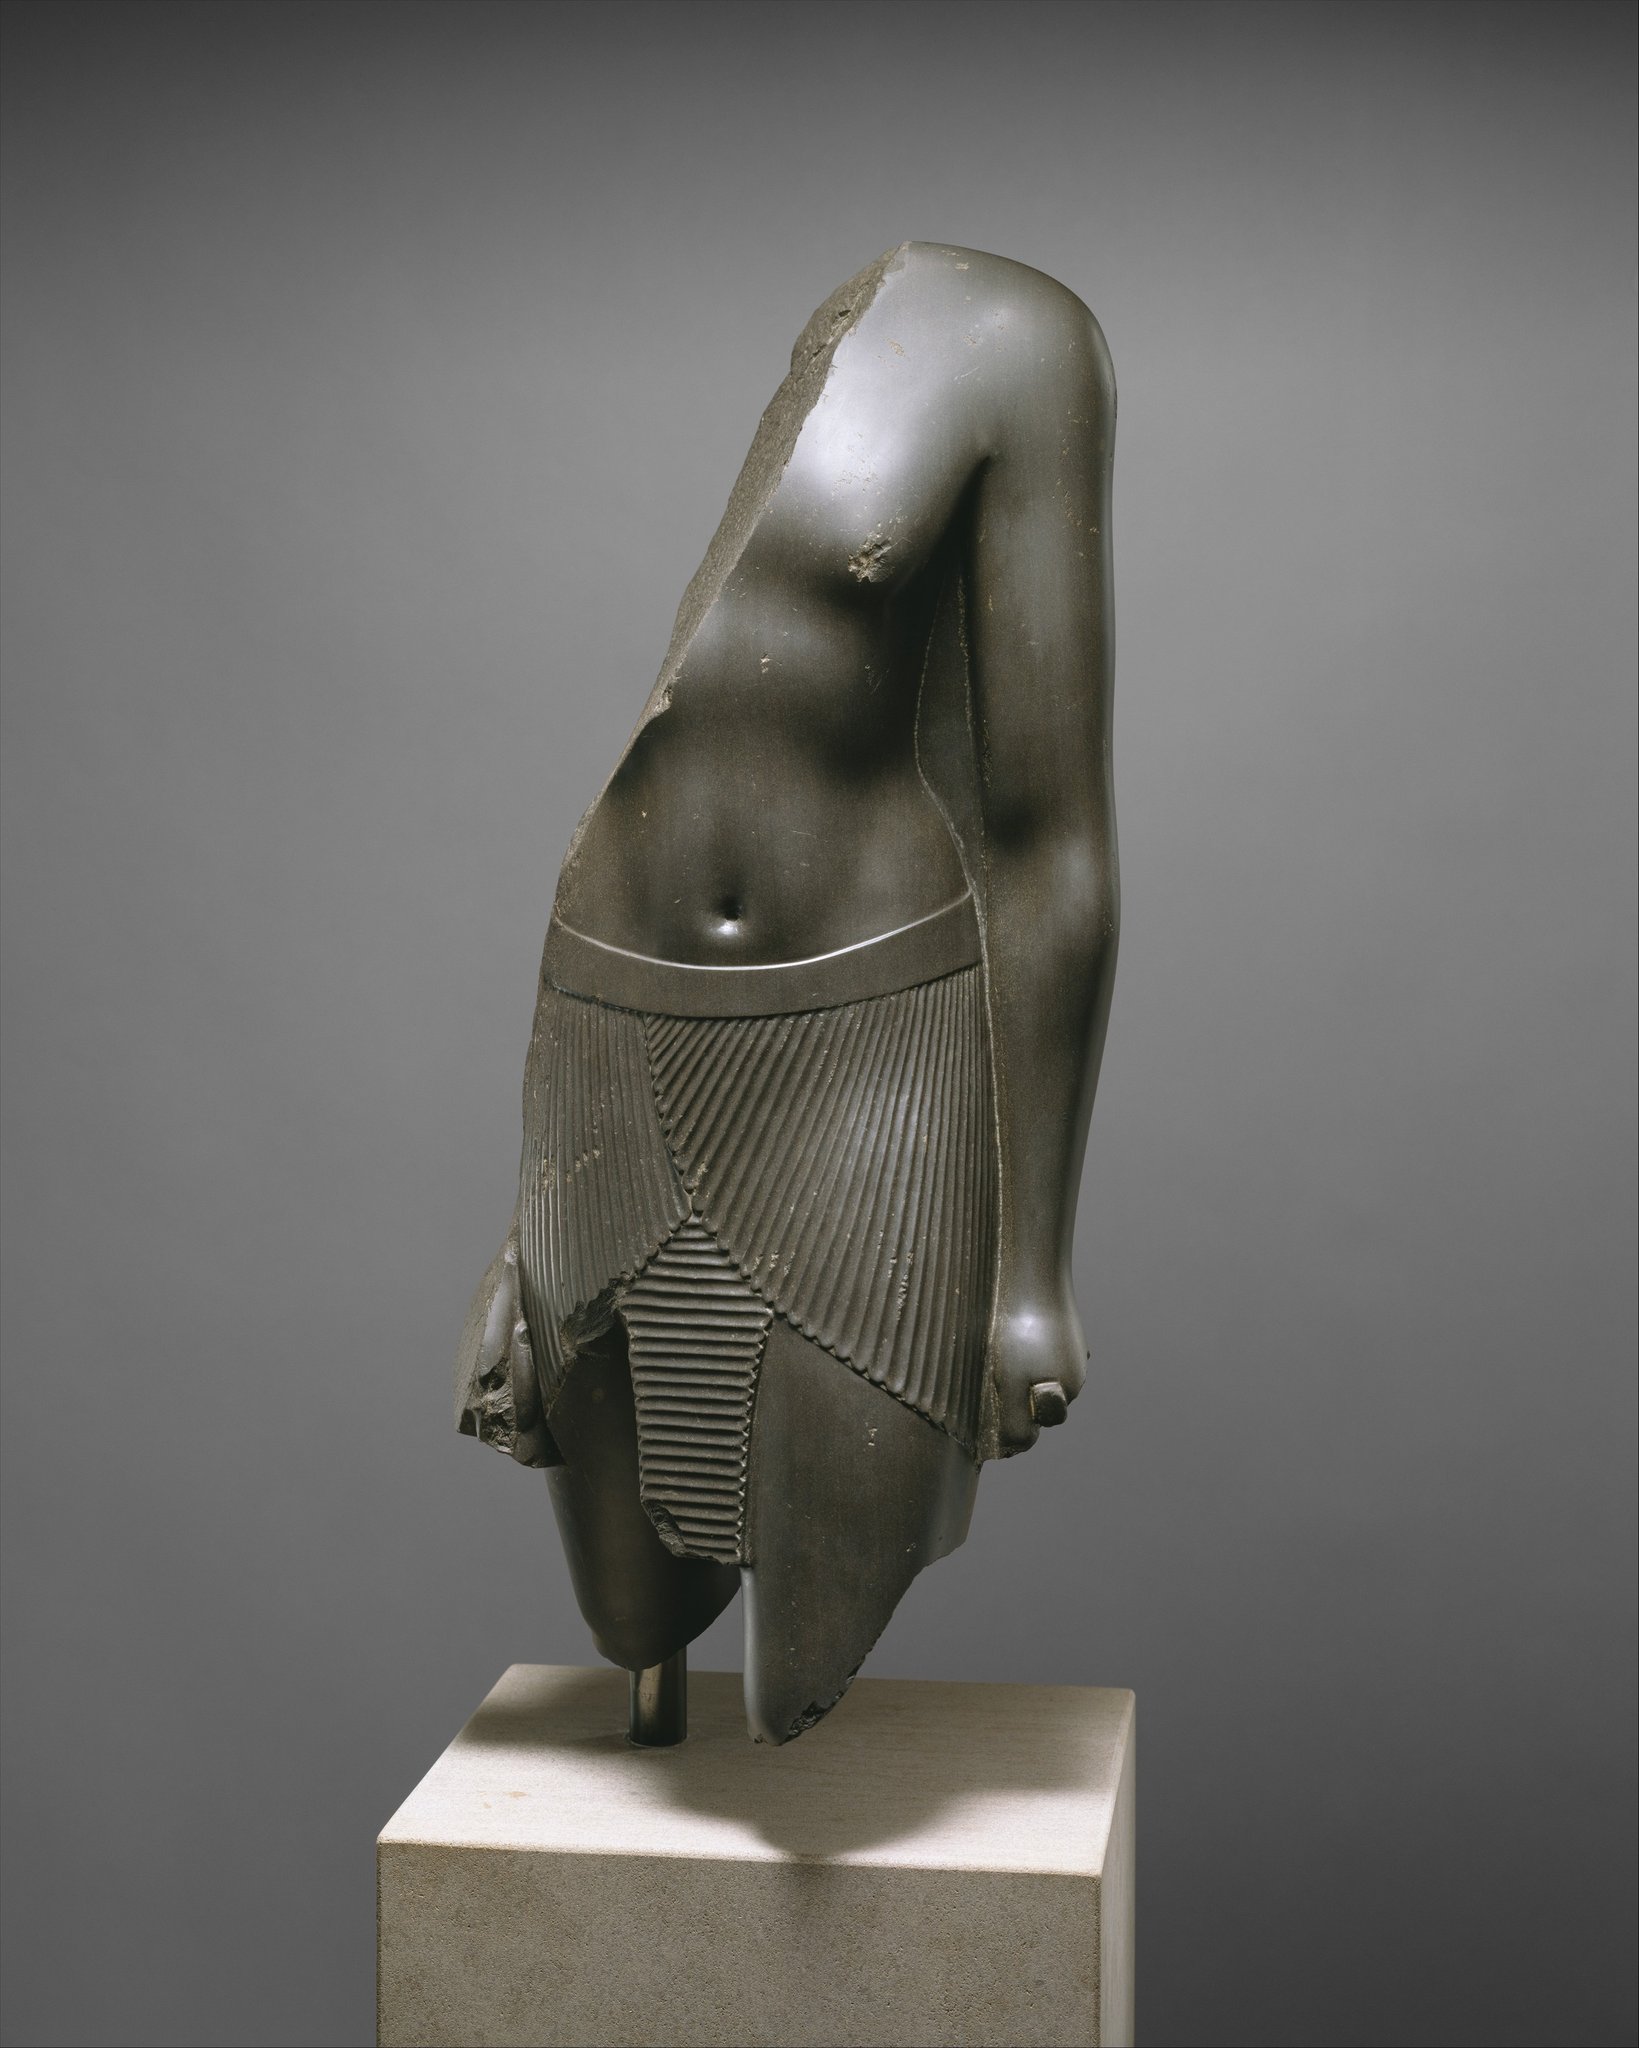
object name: statue, torso, striding general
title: Torso of a High General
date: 400-301 BCE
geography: egypt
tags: men,hieroglyphs